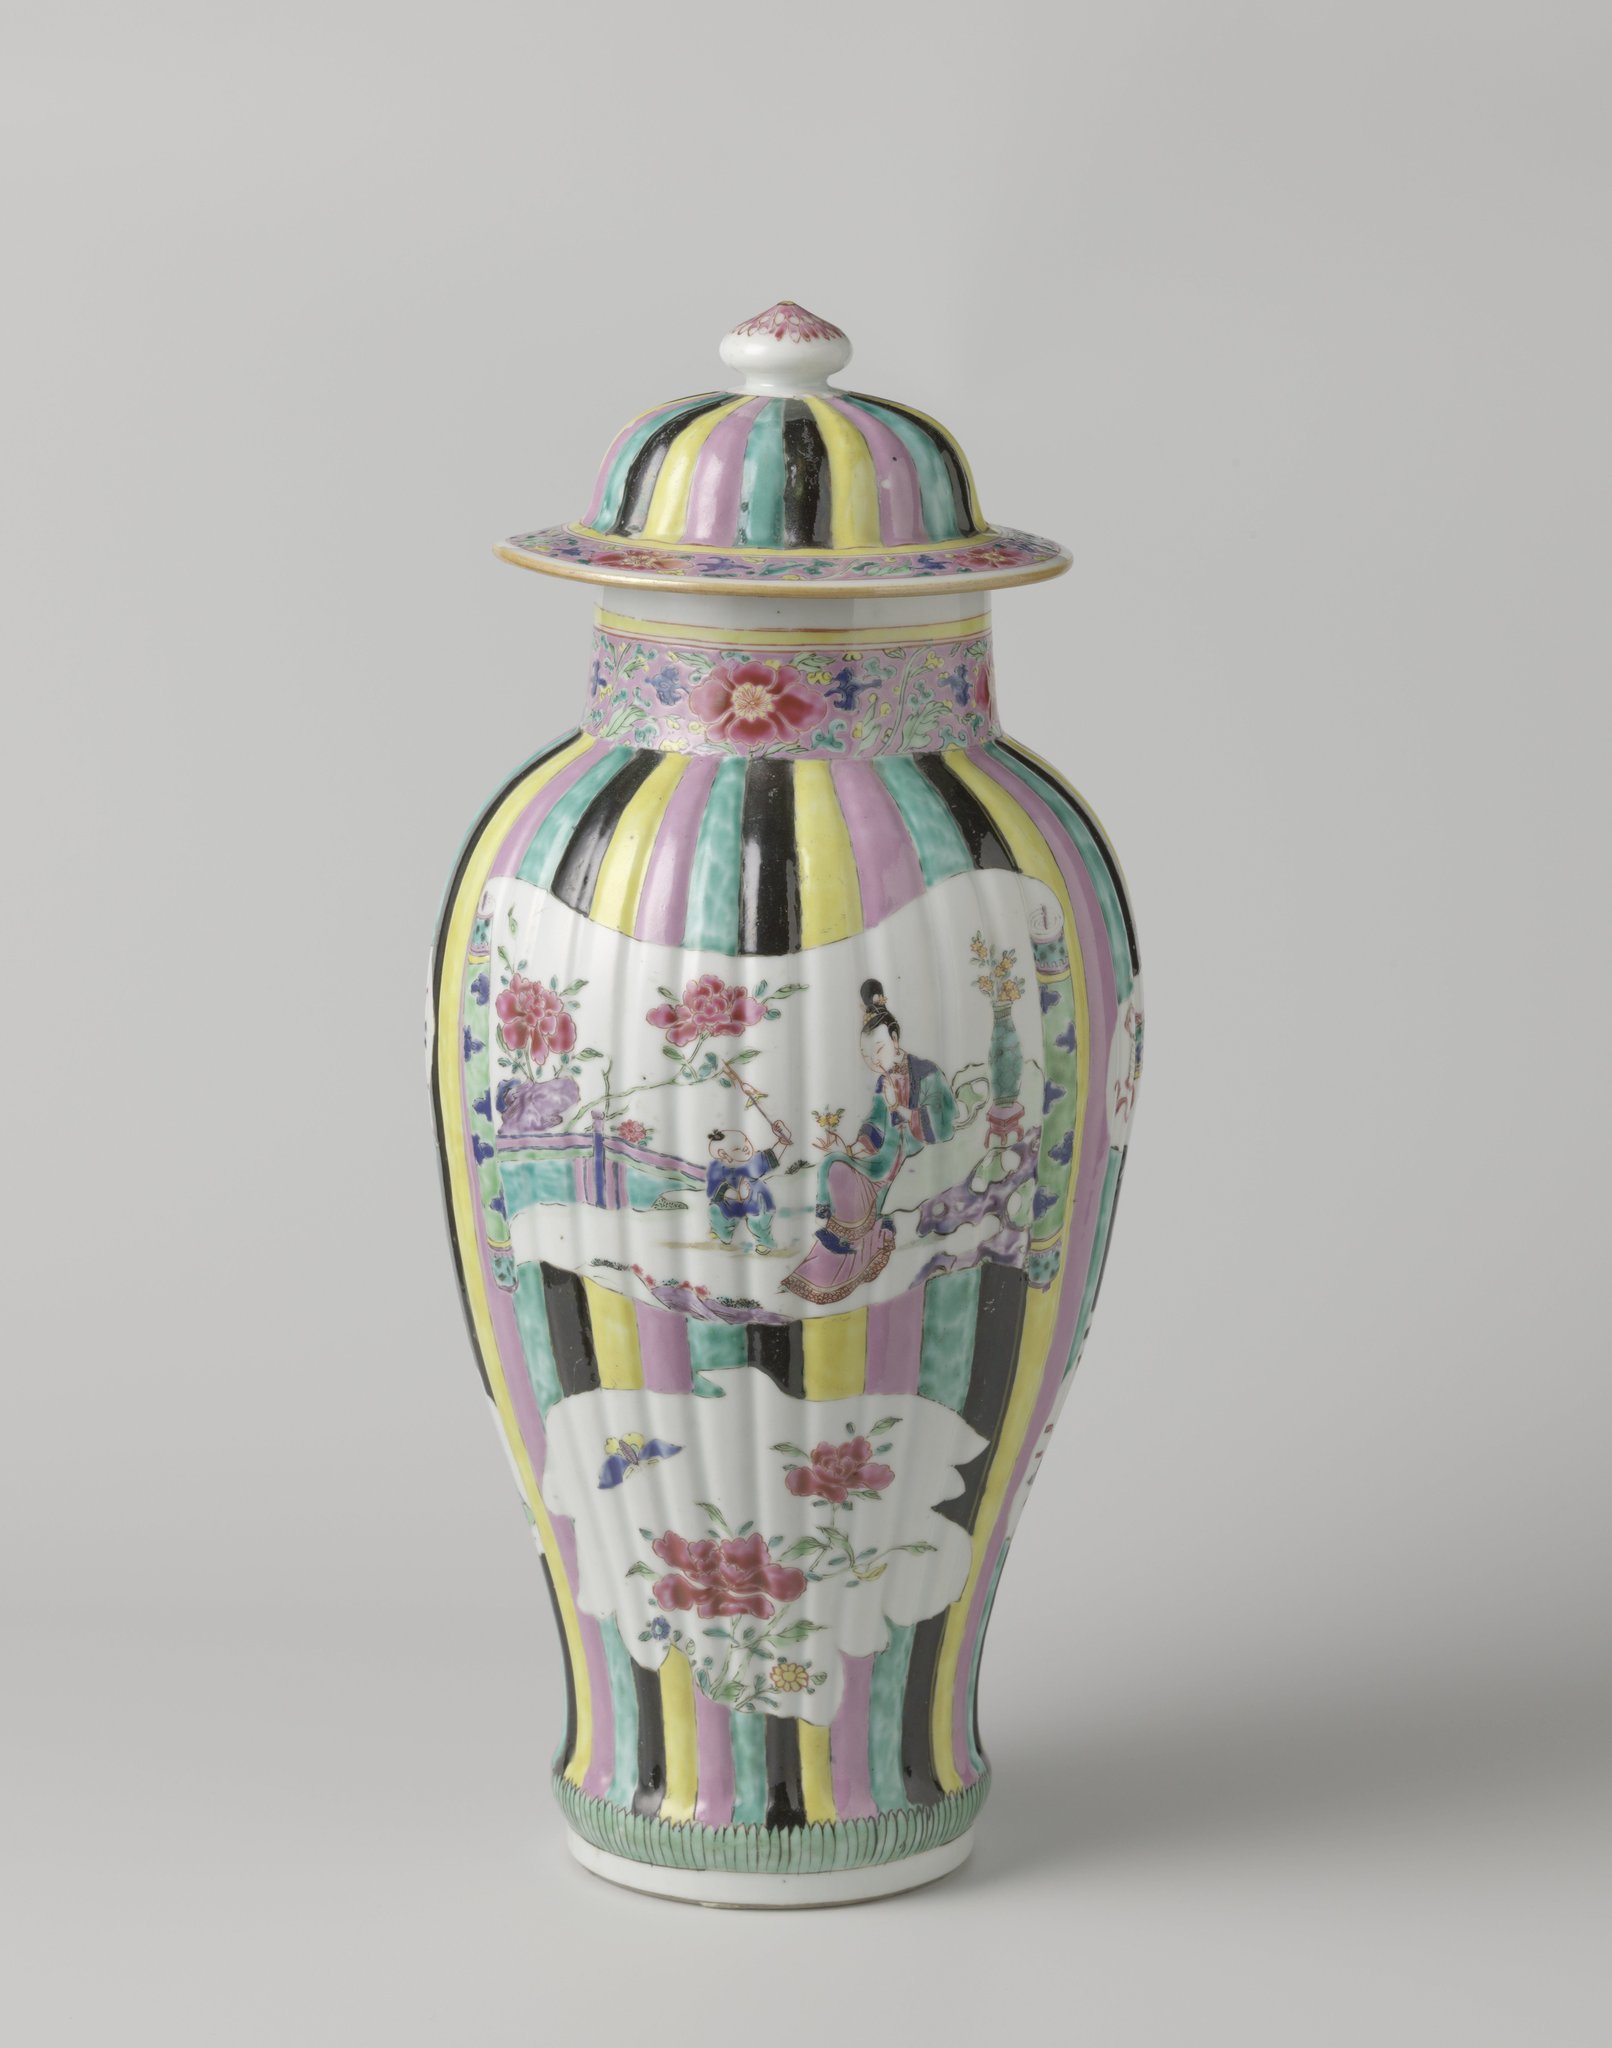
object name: covered jar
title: Covered jar with figures, flower sprays and auspicious symbols in shaped panels on a multi-colored ground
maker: Anonymous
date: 1725-1740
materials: glaze, gold, paint, porcelain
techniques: firing, forming, gilding, turning, vitrification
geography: china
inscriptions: label: ‘17100/ 91 [...]003/ 5’, label: ‘S.K. 21’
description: Dekselpot met harlequin motief behorend bij vijfdelig kaststel.